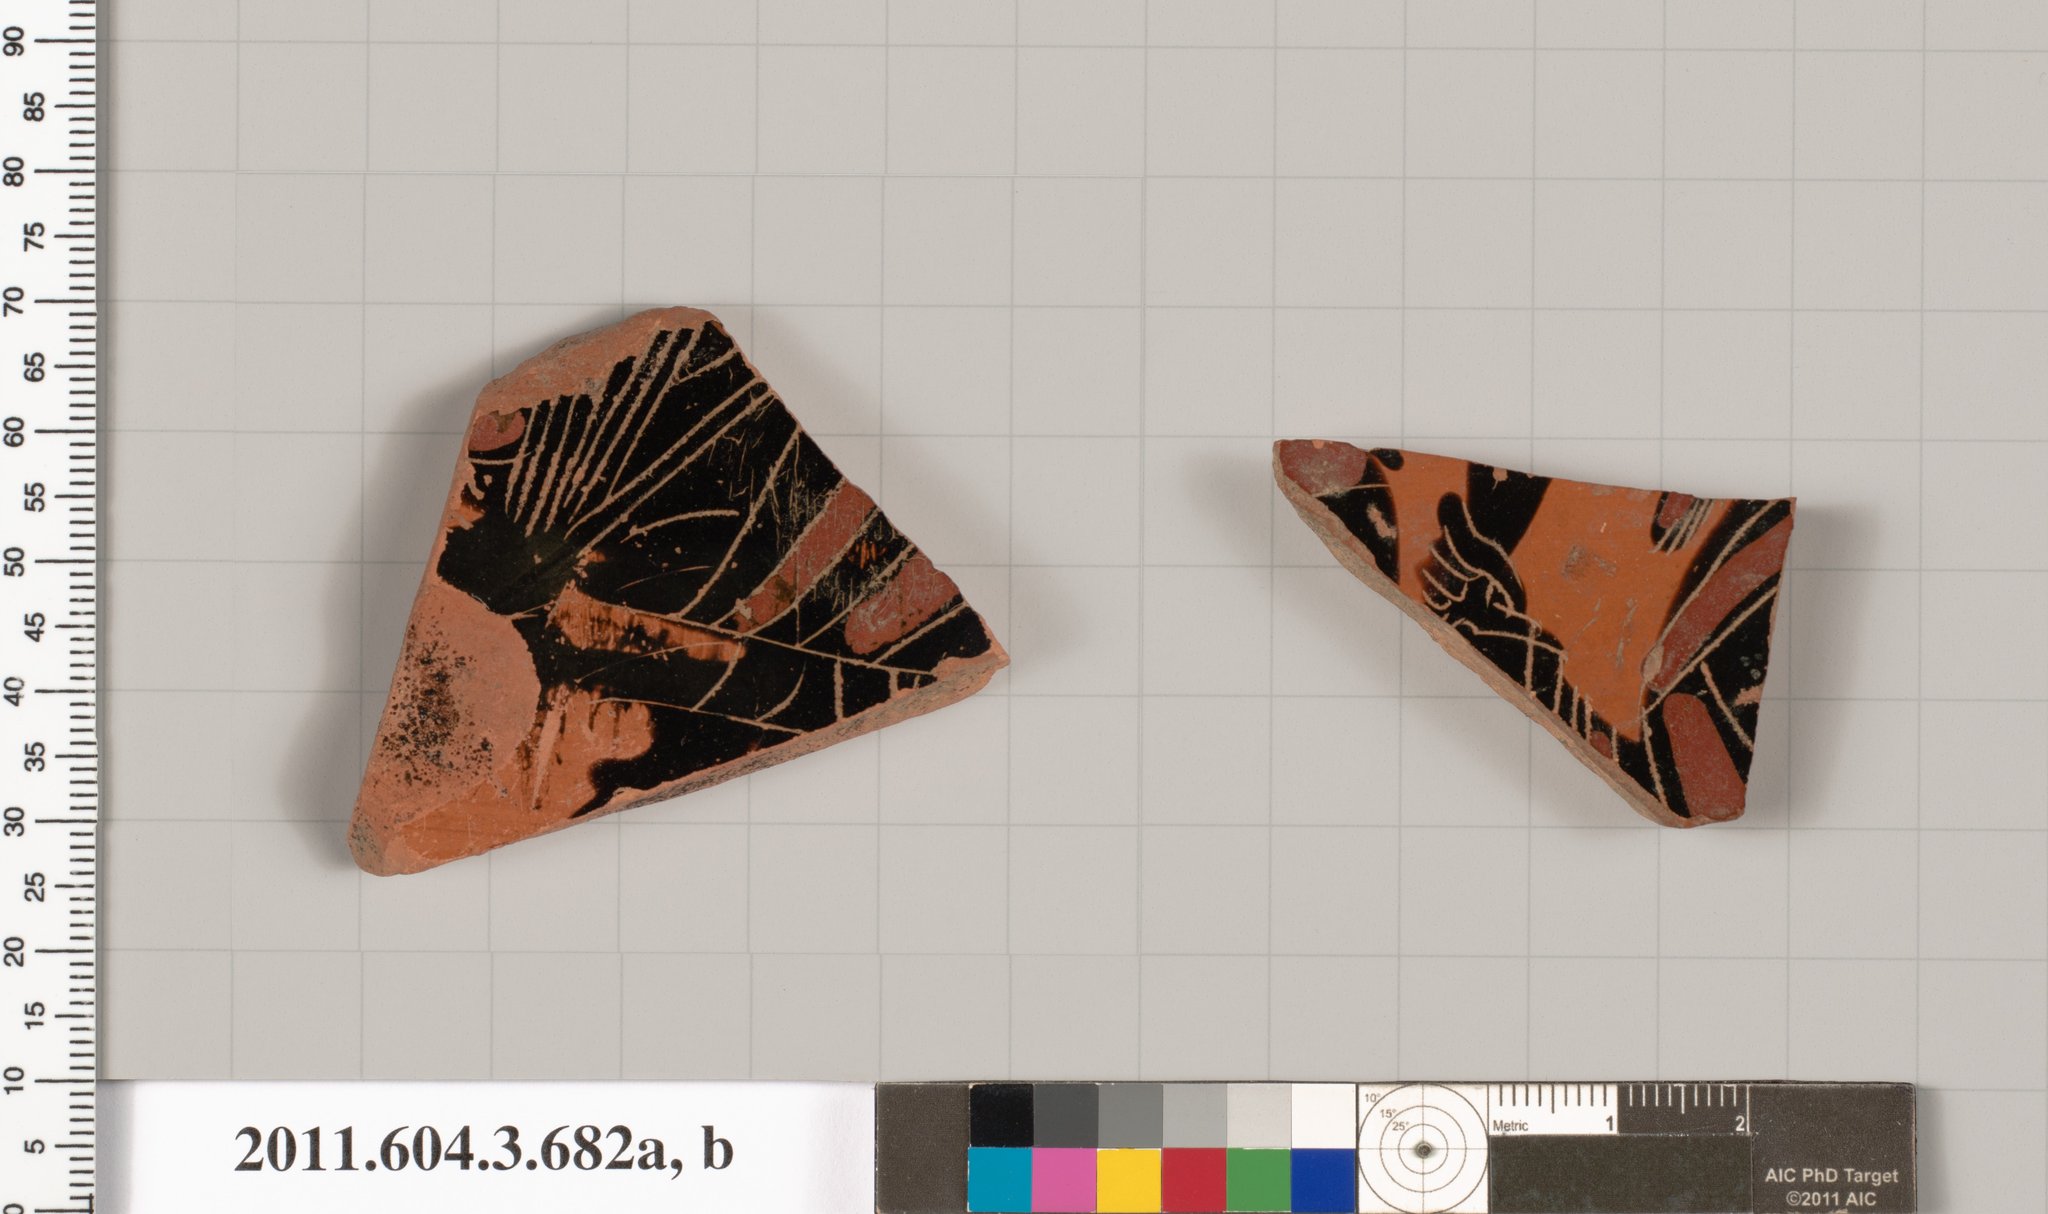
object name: stamnos fragment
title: Terracotta fragments of a stamnos (jar)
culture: greek, attic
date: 510-500 BCE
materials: terracotta